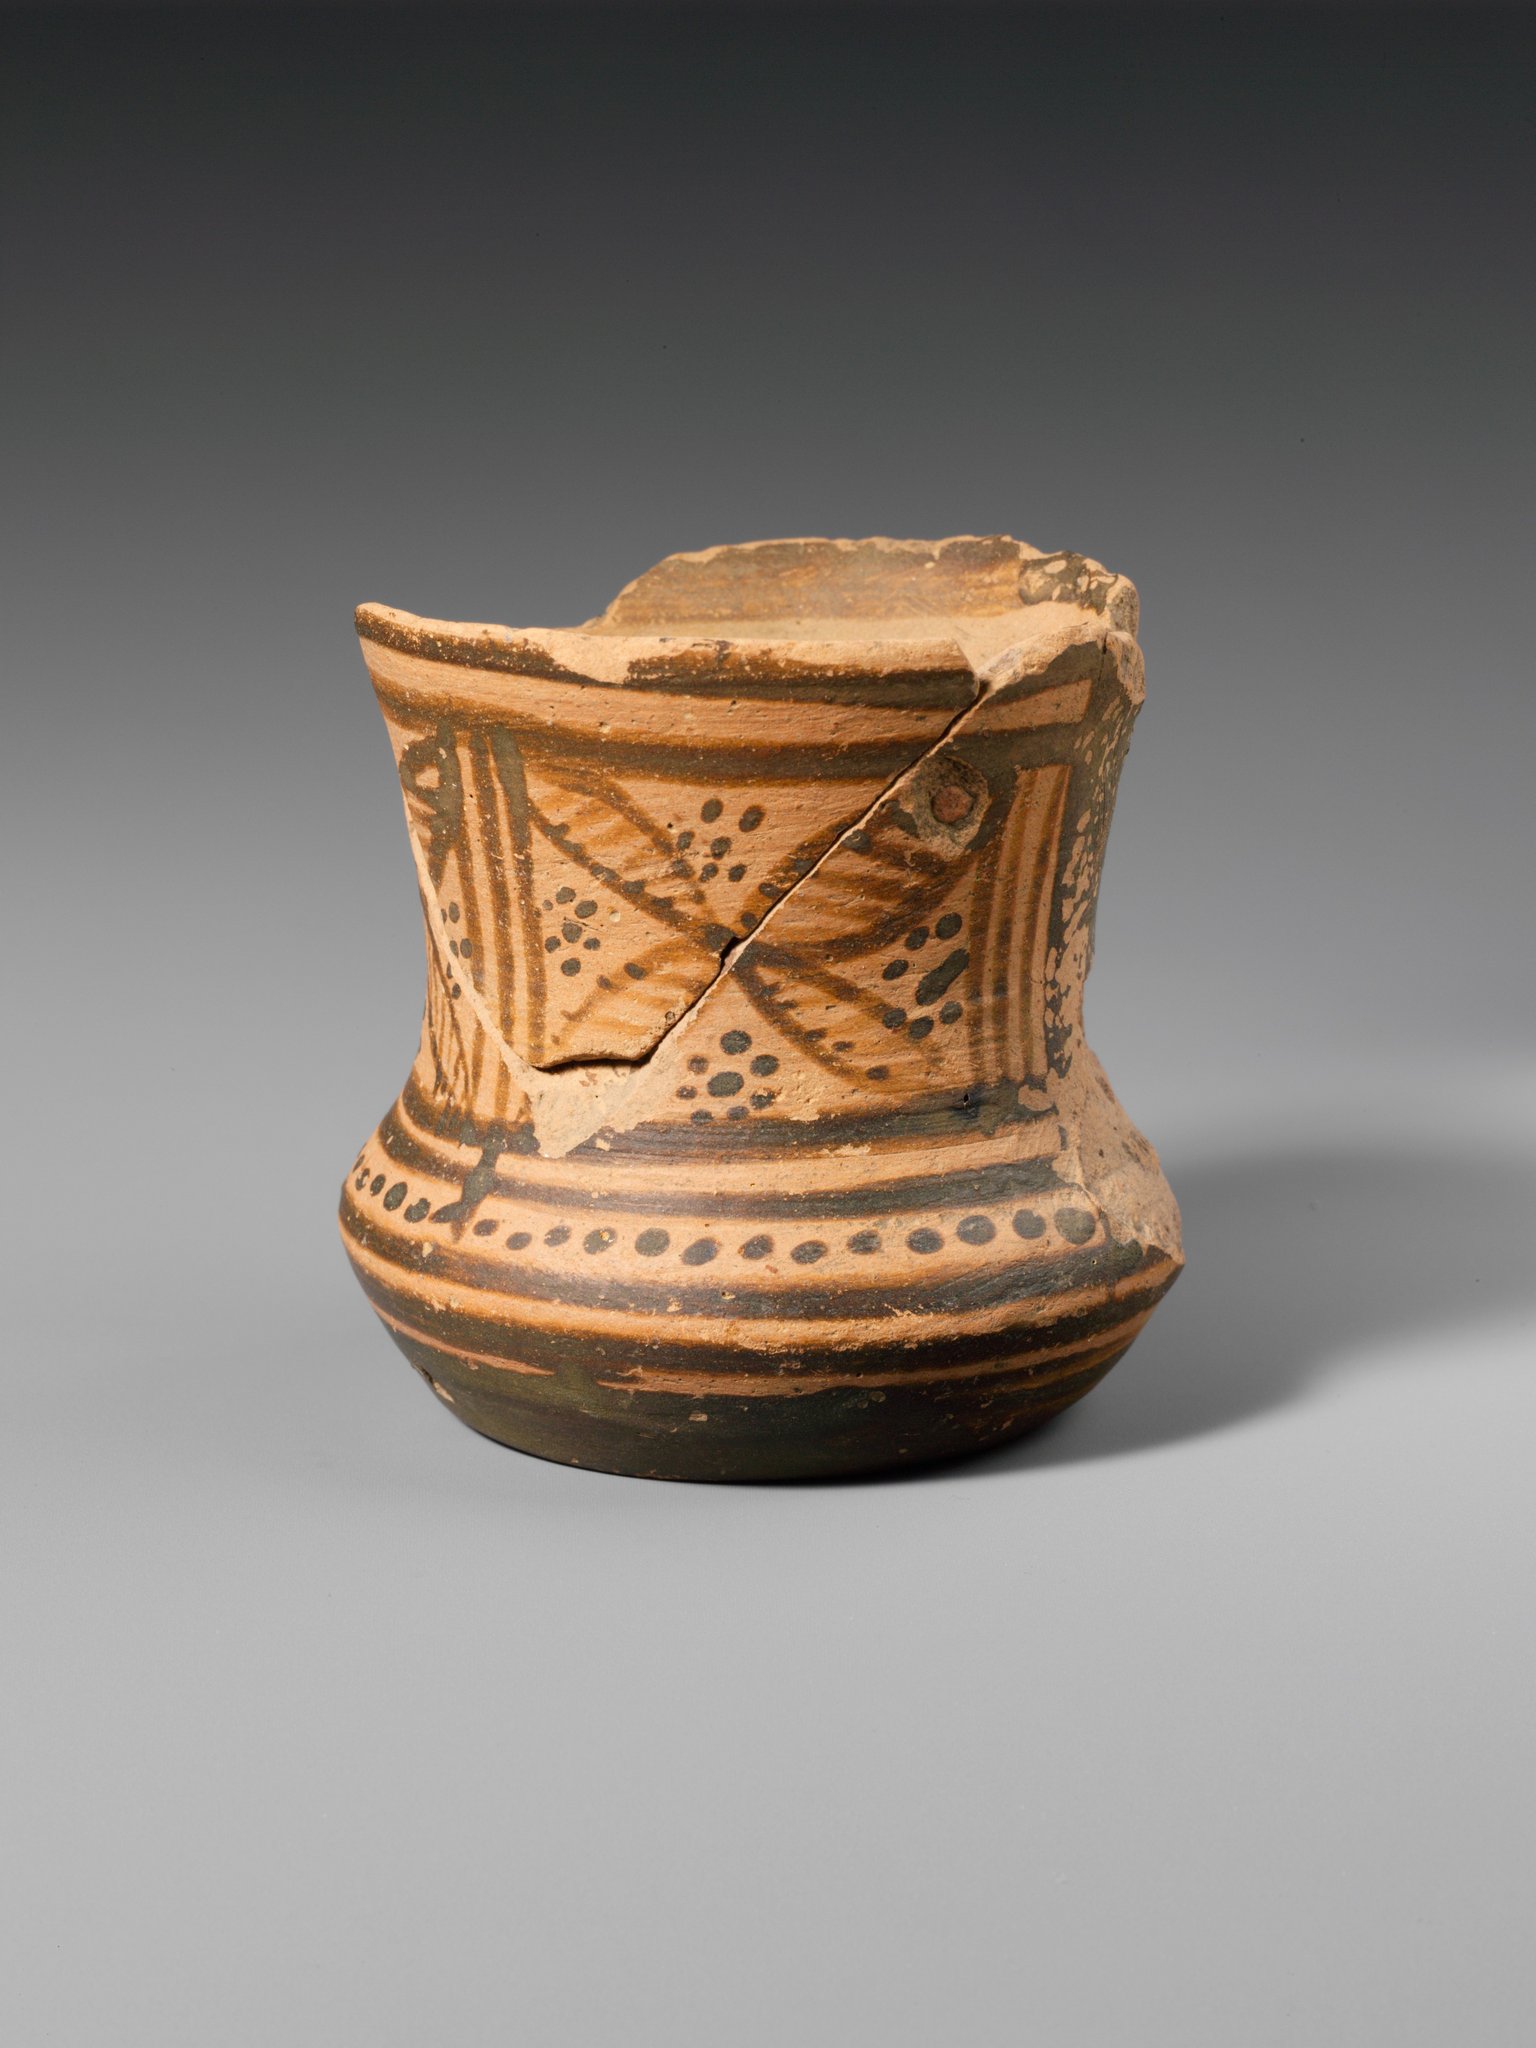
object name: tankard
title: Terracotta tankard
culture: greek, attic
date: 734-701 BCE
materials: terracotta